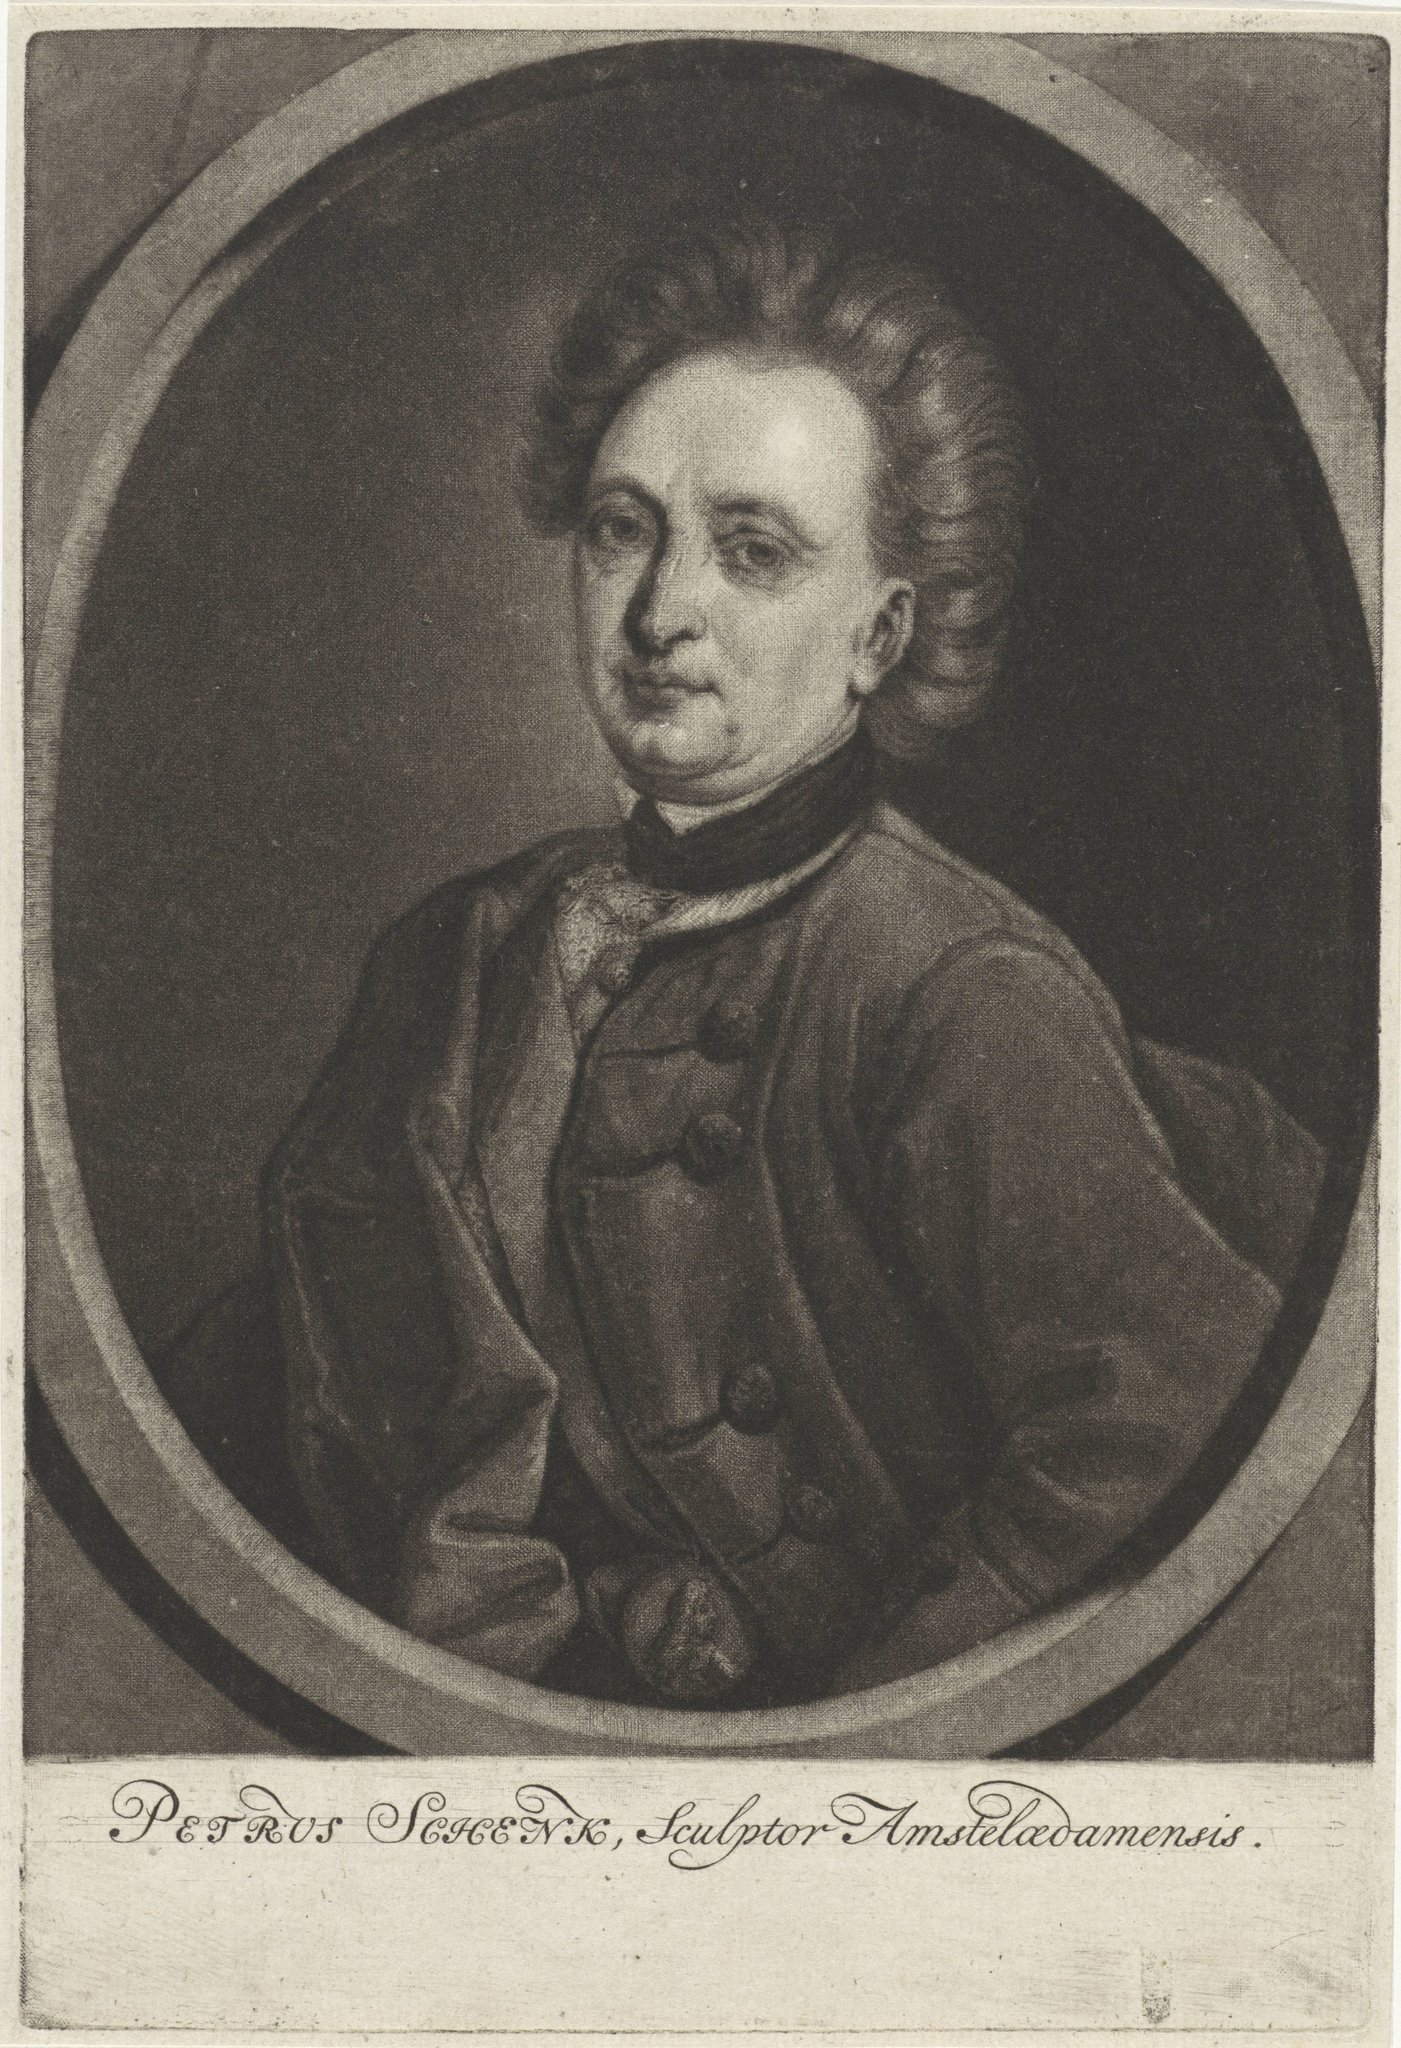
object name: print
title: Portret van Pieter Schenk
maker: pieter schenk (i)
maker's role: print maker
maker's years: 1660-1711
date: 1680-1713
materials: paper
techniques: engraving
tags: print maker, pieter schenk (i), portrait, self-portrait of artist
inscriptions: collector's mark: Lugt 2228